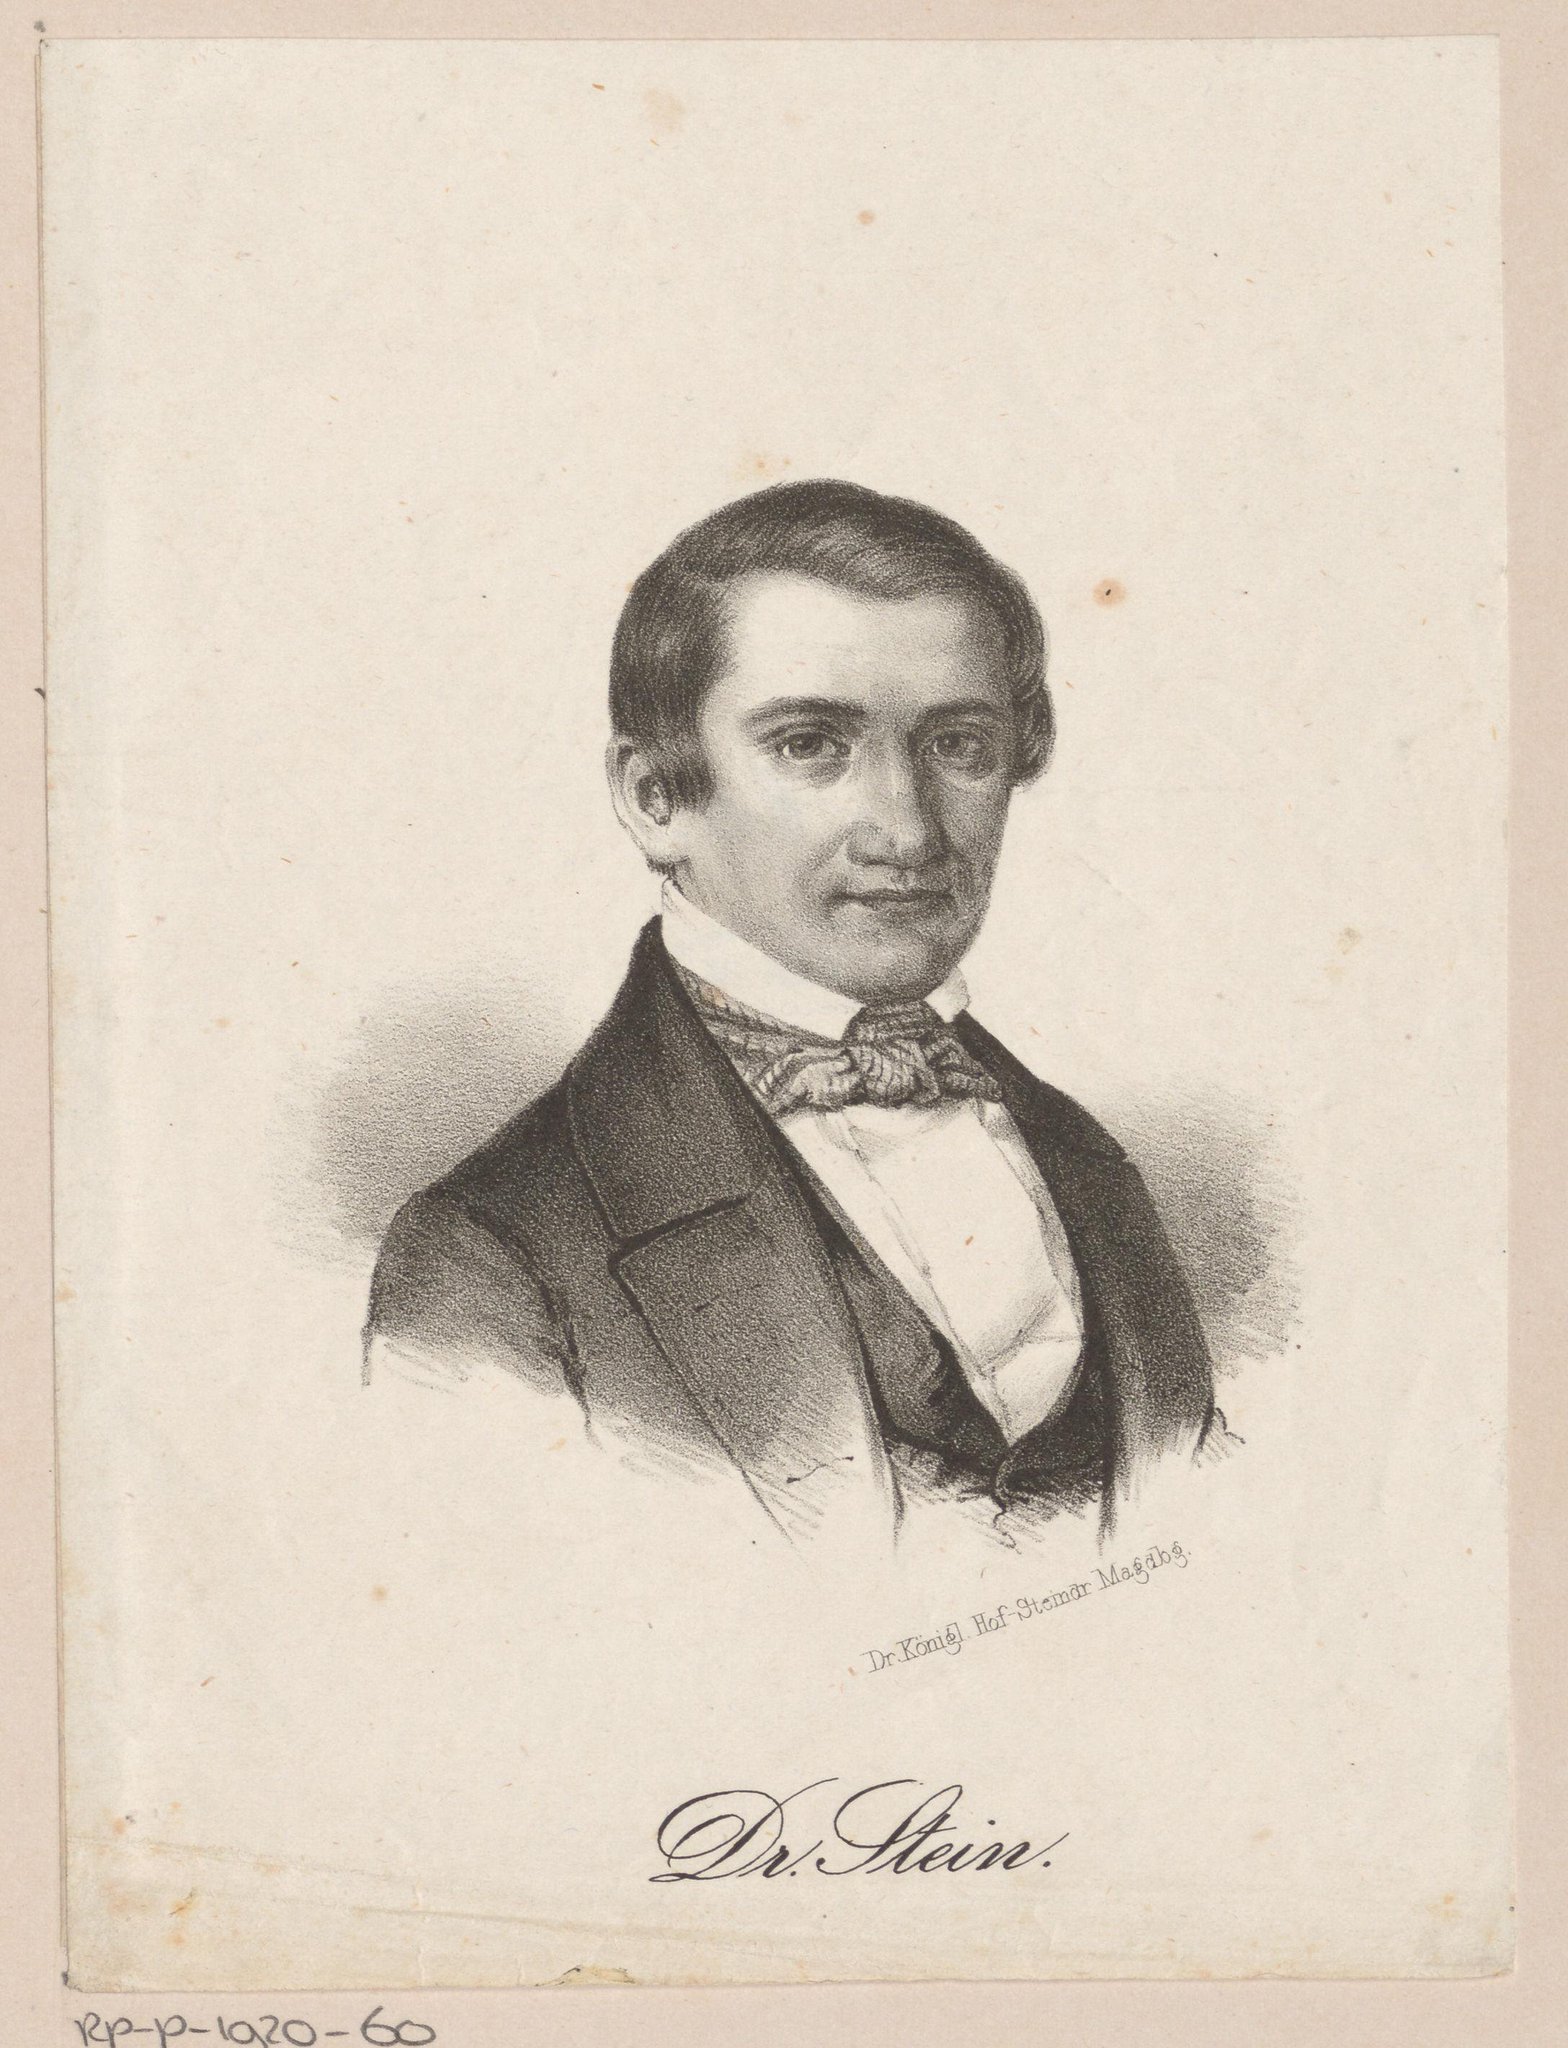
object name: print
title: Portret van Julius Stein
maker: Anonymous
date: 1838-1899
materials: paper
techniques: lithograph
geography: magdeburg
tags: journalist, reporter, historical persons, politician, e.g. party leader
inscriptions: collector's mark: Lugt 2228